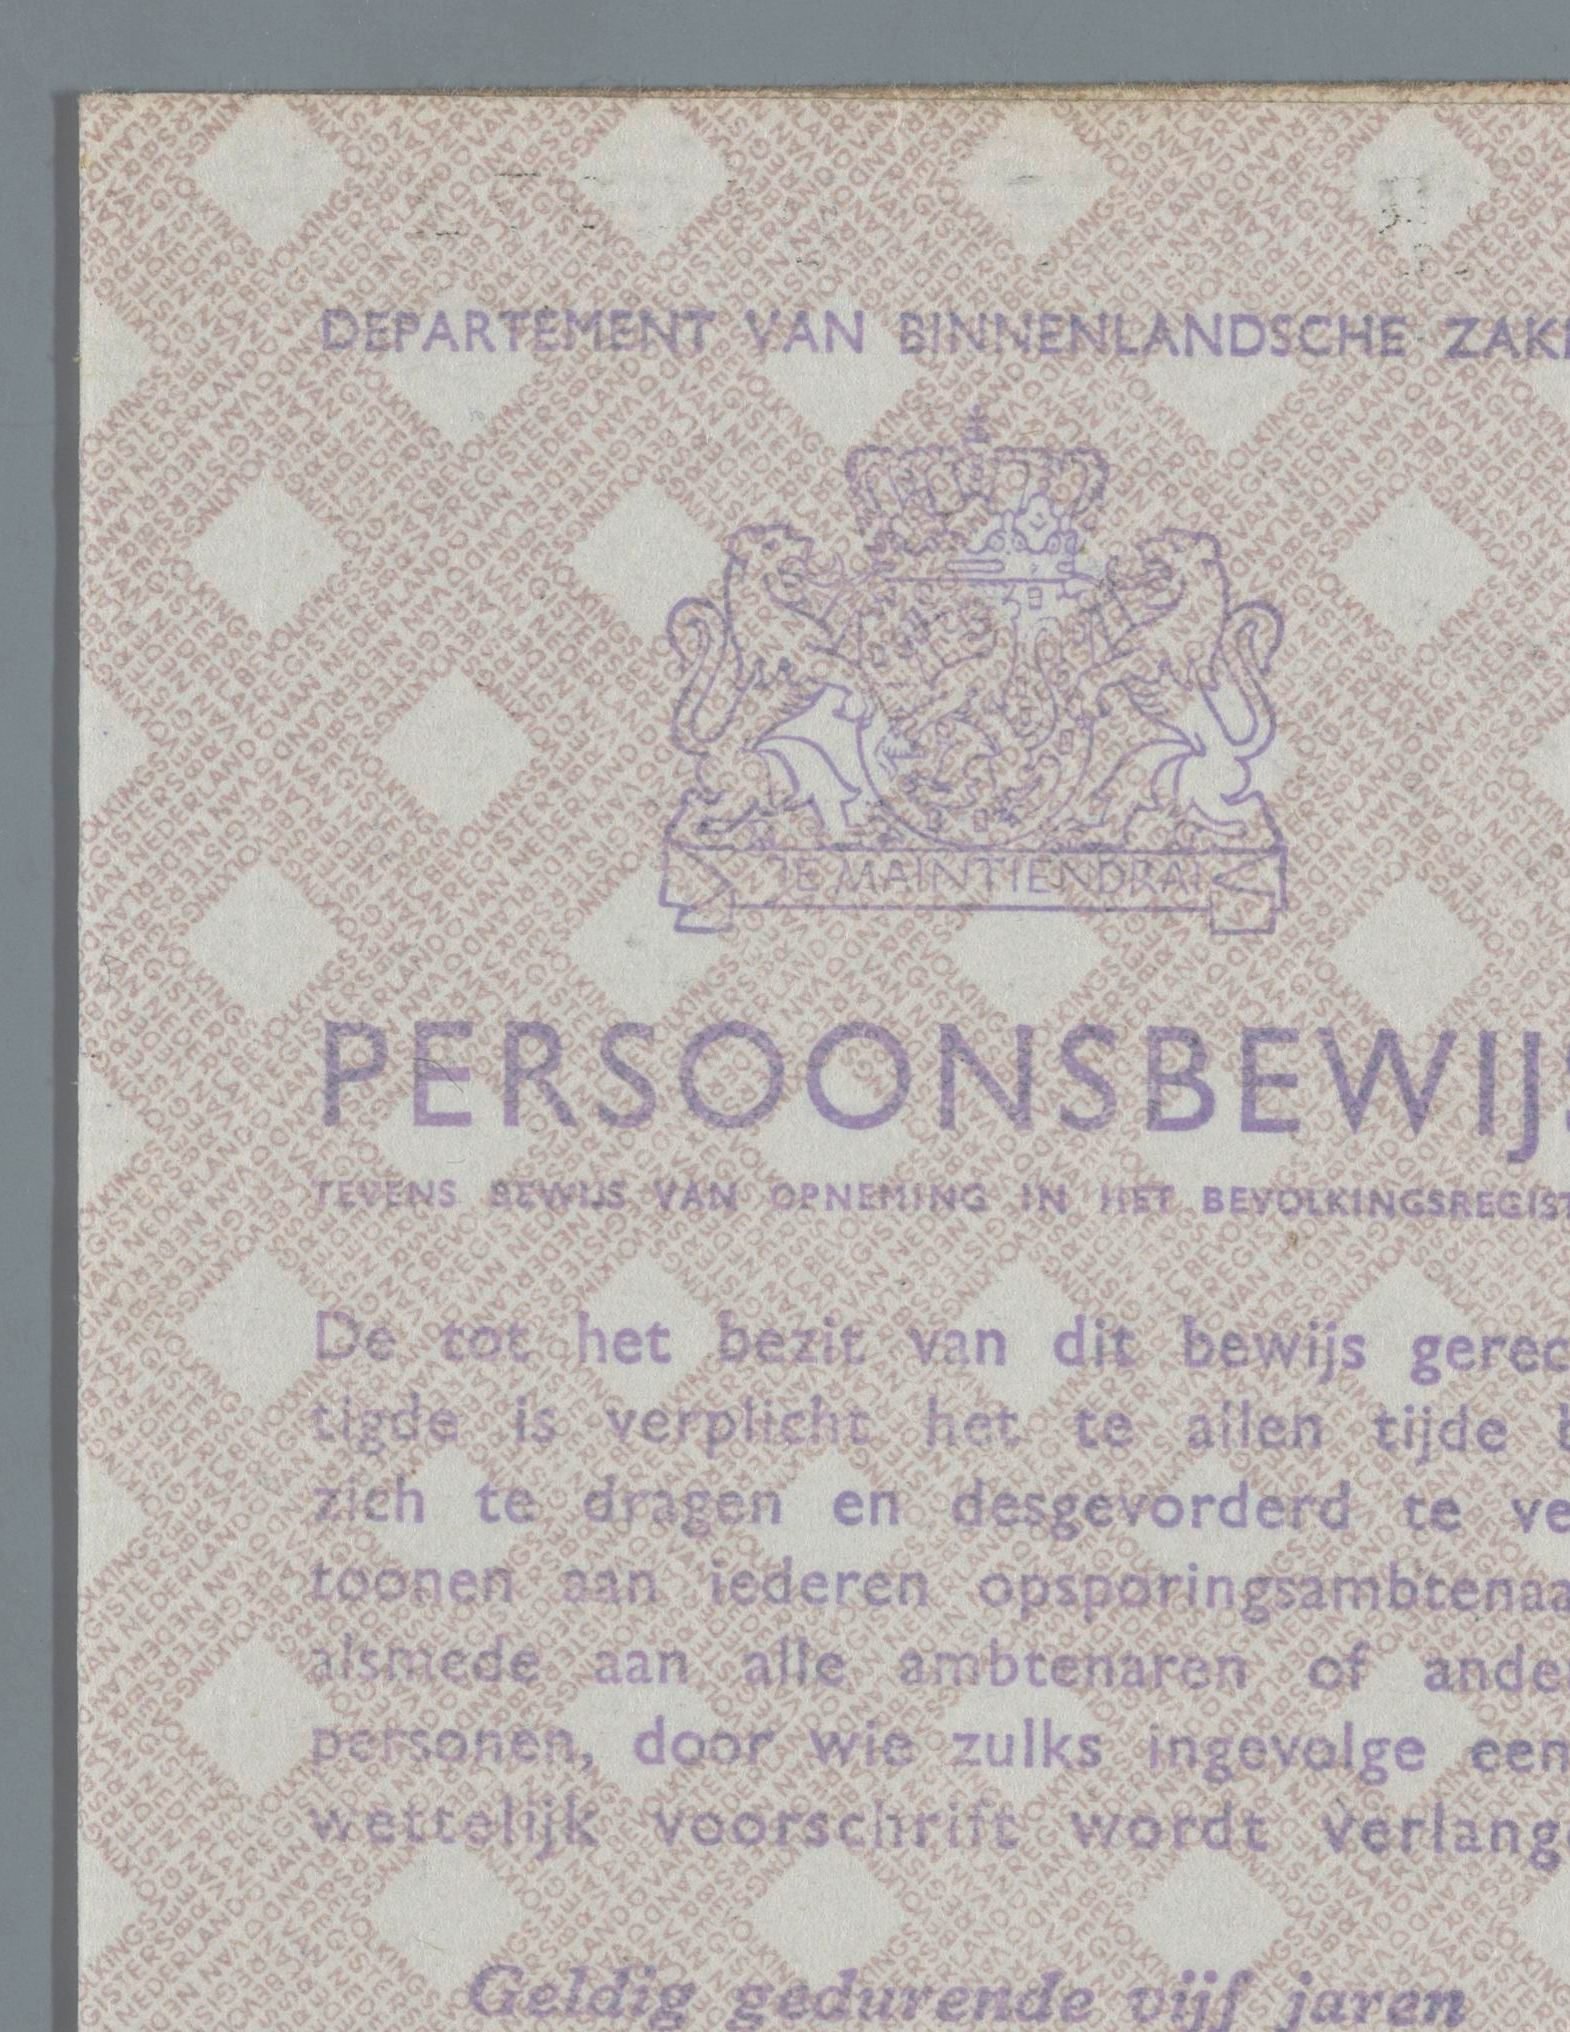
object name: photograph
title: Persoonsbewijs van Wilhelmina Gerarda Hoogendijk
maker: Anonymous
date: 1941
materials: paper, photographic support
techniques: gelatin silver print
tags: historical persons - bb - woman, passport, visa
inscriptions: inscription: ‘Gemeente Maastricht’